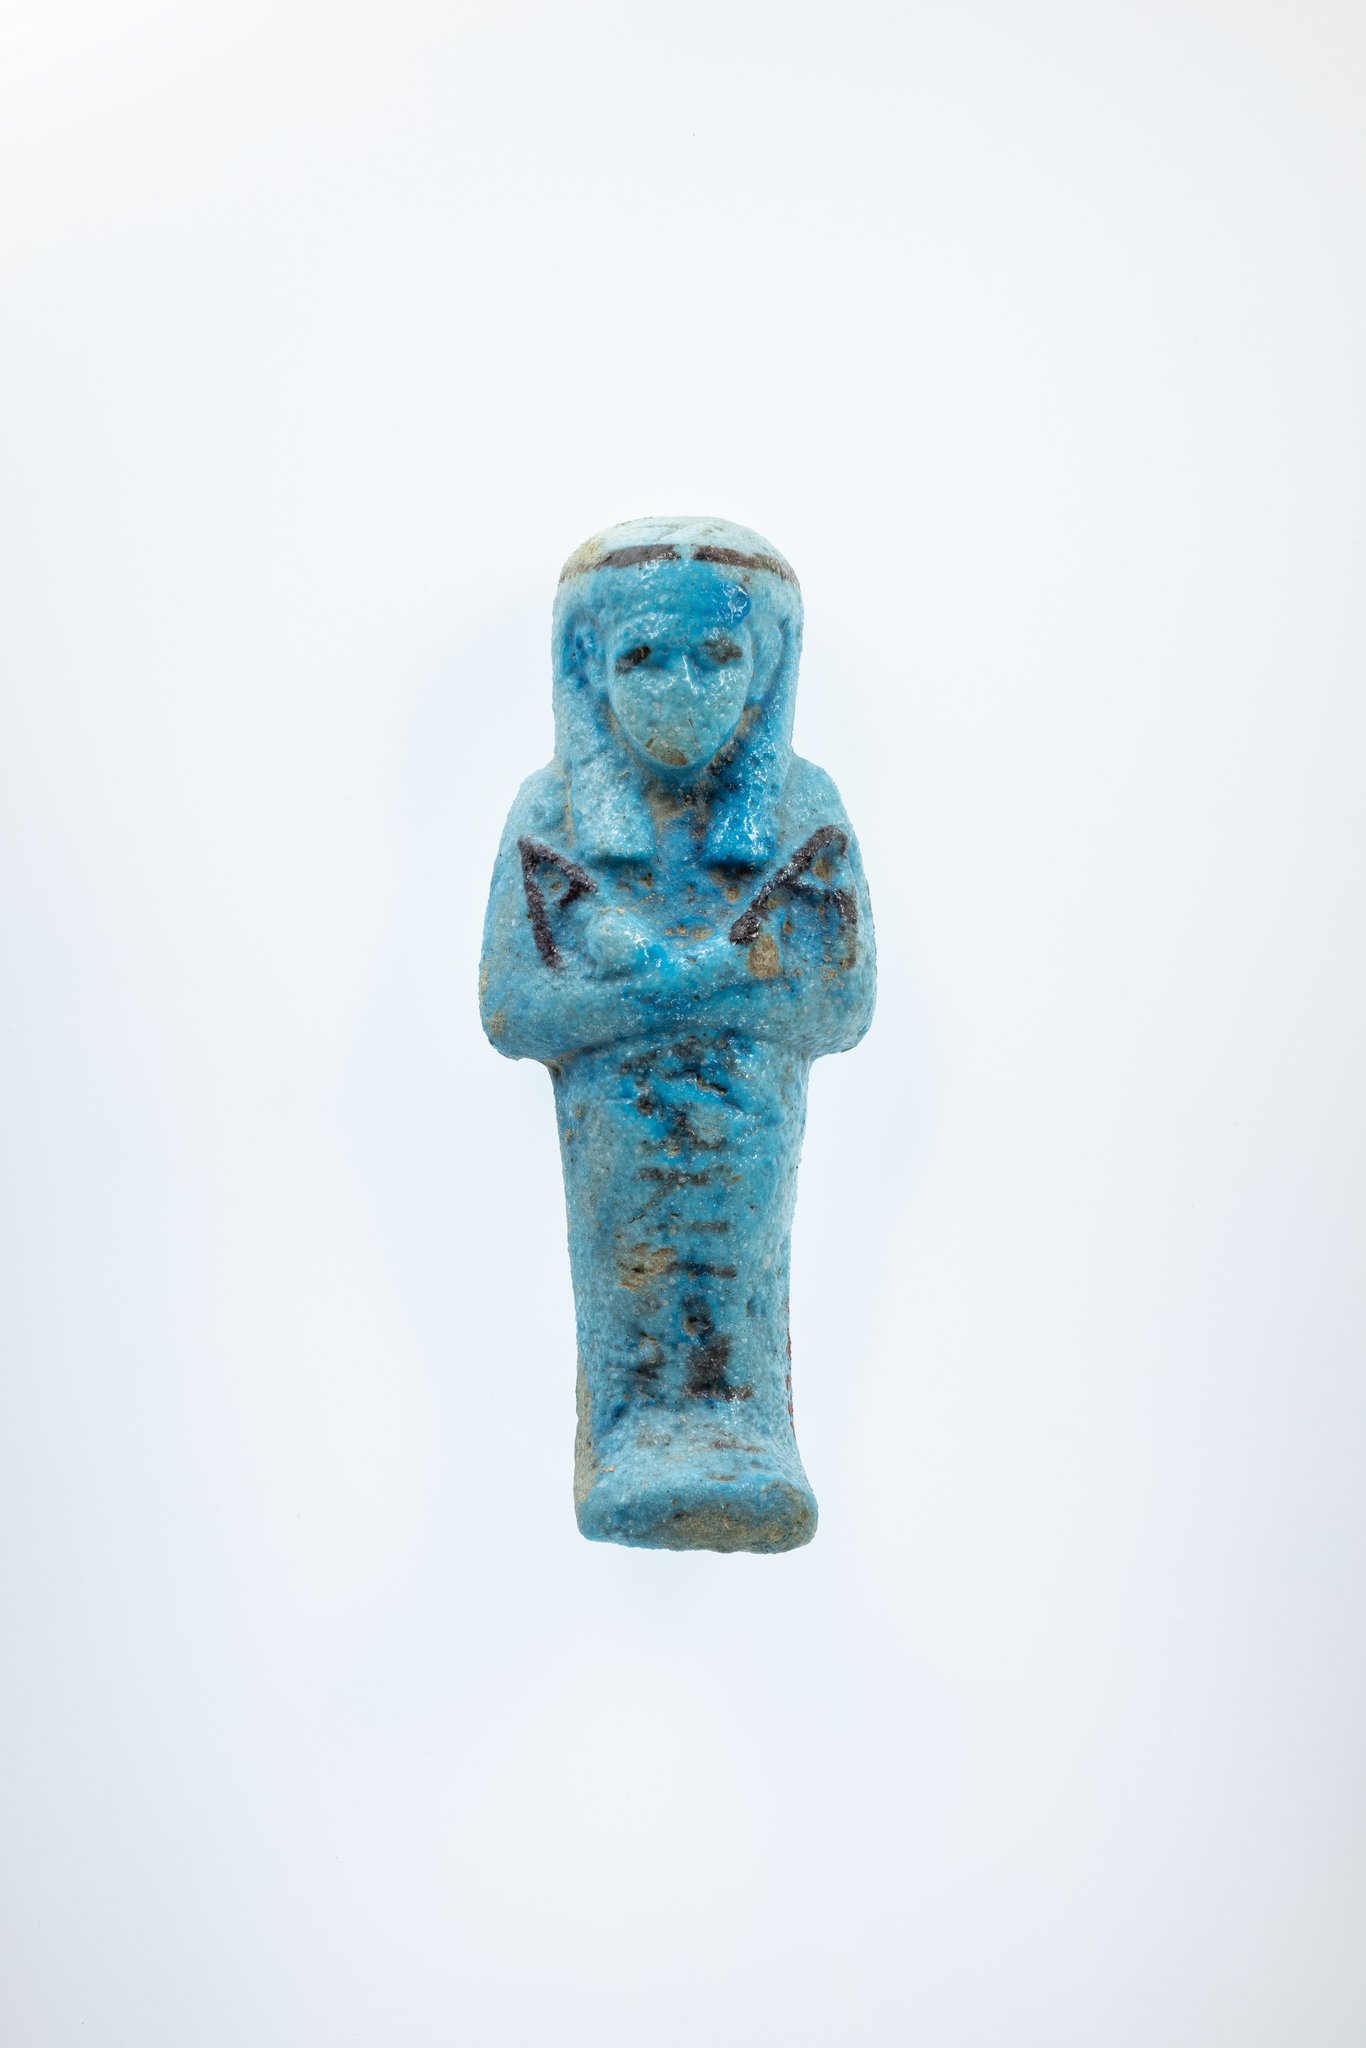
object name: shabti, nesenaset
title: Shabti of Nesenaset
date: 1070-945 BCE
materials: faience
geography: egypt